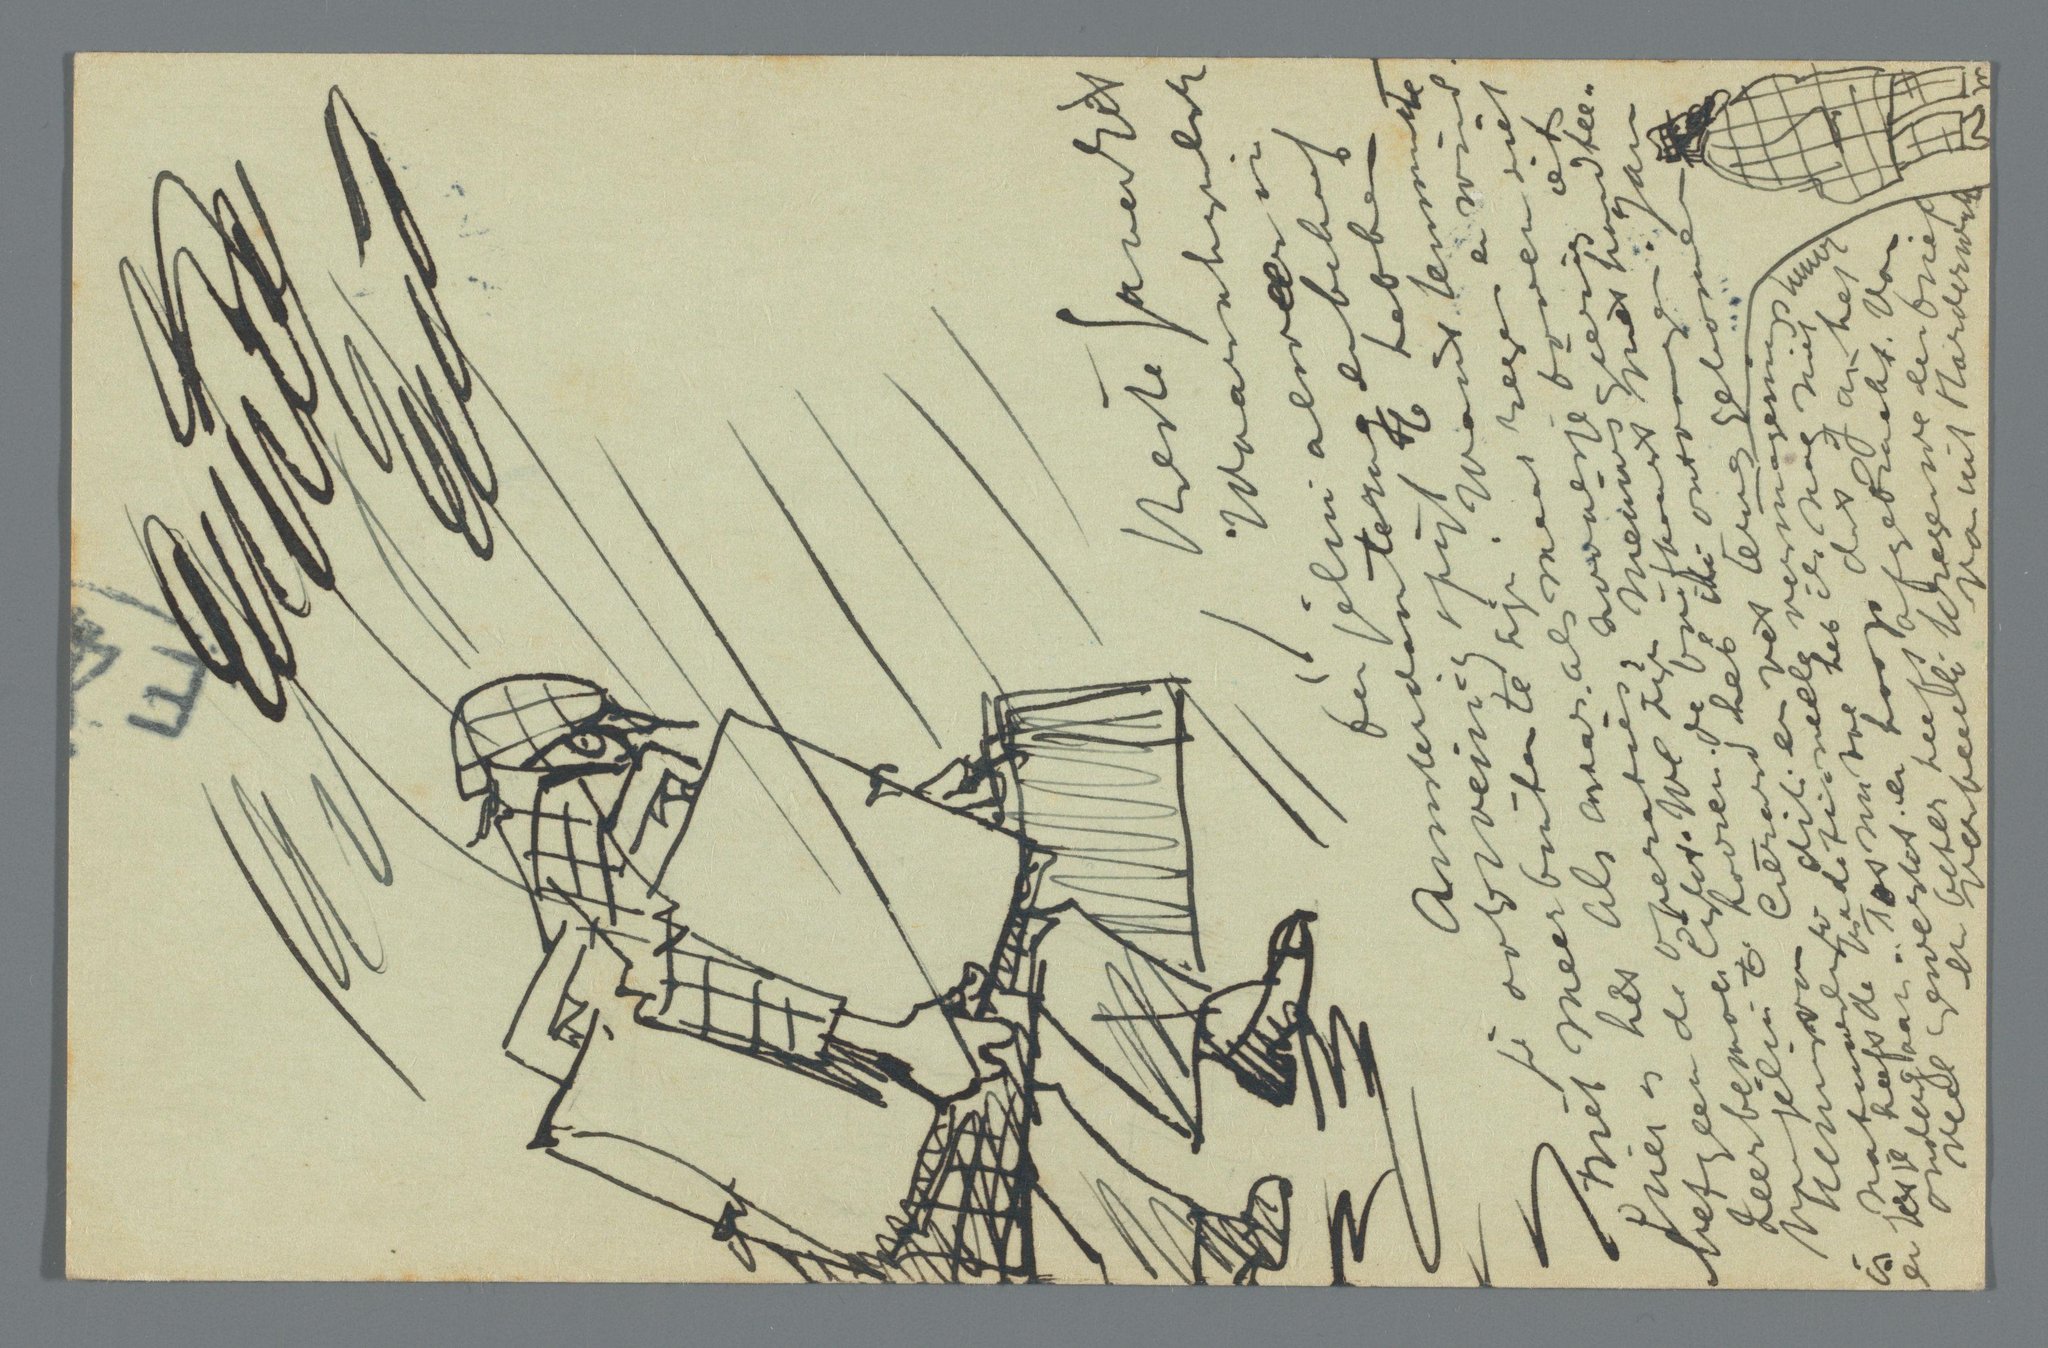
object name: drawing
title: Briefkaart aan Jan Ponstijn en Henriëtte Johanna Petronella van Hilten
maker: leo gestel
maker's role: draughtsman, print maker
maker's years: 1881-1941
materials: cardboard, ink, pencil, watercolor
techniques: brush, pen, writing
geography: bergen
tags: henriëtte johanna petronella ponstijn-van hilten, amsterdam, print maker, draughtsman, jan petrus ponstijn, ghent, gustave de smet, leo gestel, bad weather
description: Briefkaart met een tekening van een man, vermoedelijk Leo Gestel, die gebukt en met een map en schilderij onder de arm en een tas in de hand door regen en wind loopt. Rechtsonder een tekening van een dikke man in een geruit pak die Jan Ponstijn moet voorstellen. Briefkaart maakt deel uit van een album.